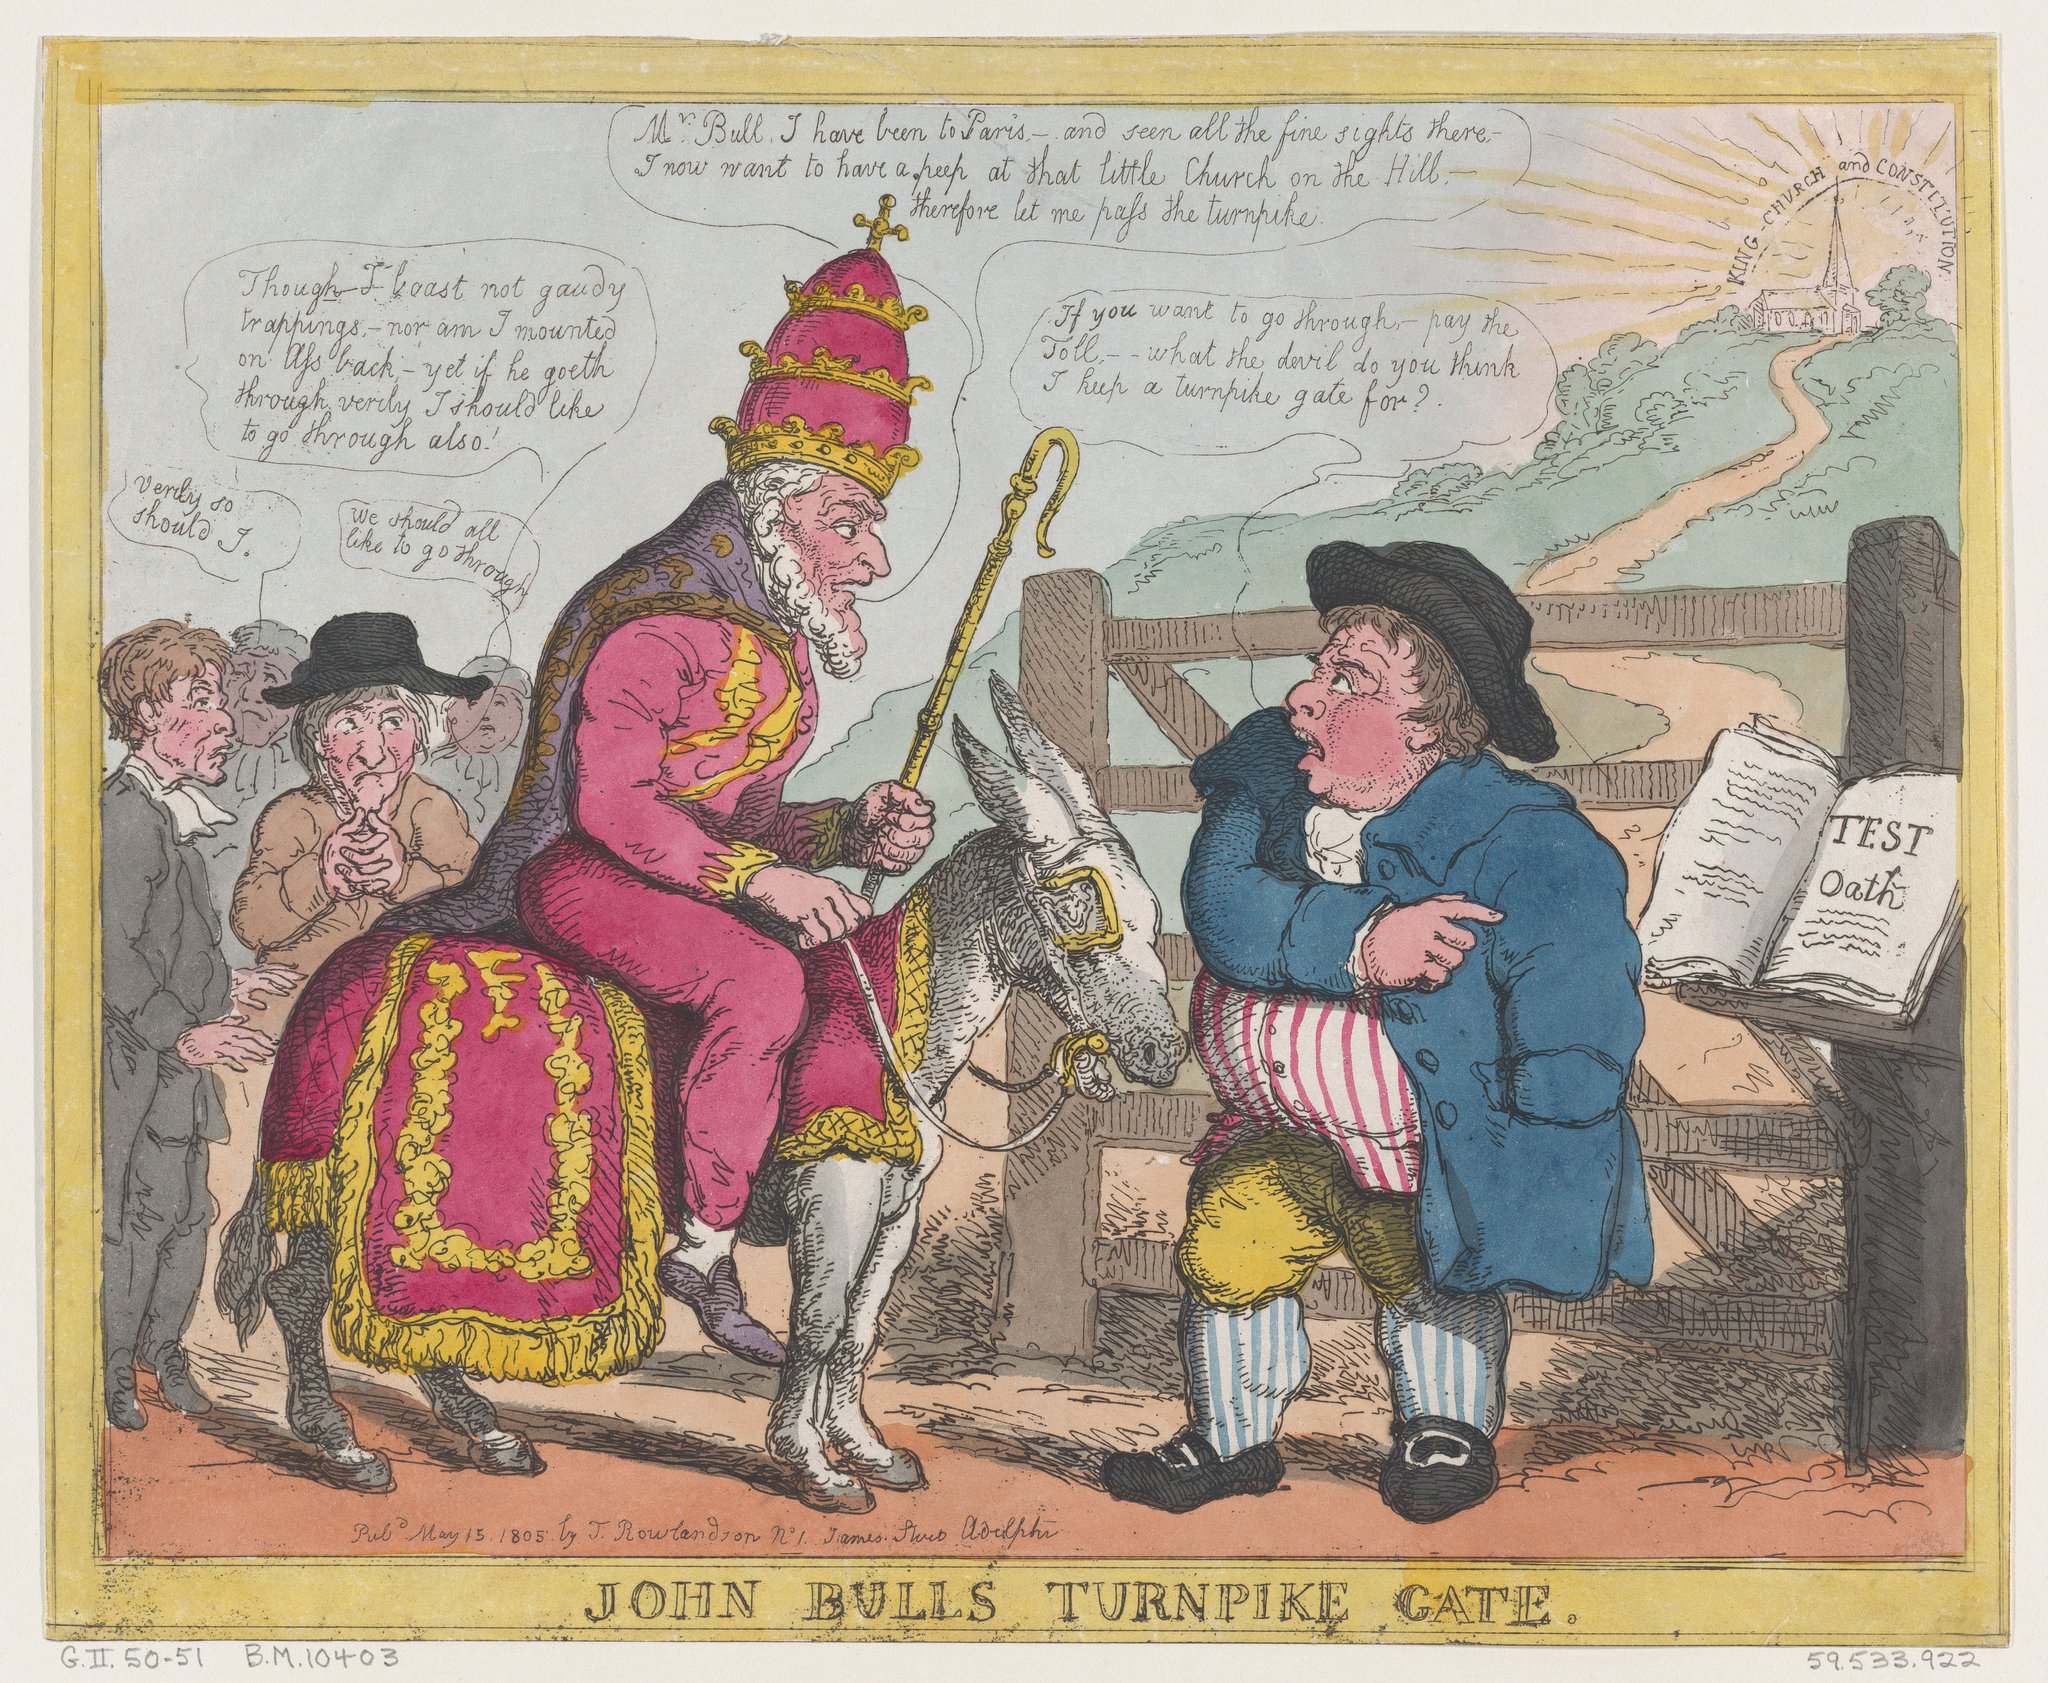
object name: print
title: John Bull's Turnpike Gate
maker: thomas rowlandson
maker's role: artist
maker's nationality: british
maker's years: 1757-1827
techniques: etching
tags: satire,men,donkeys,politics